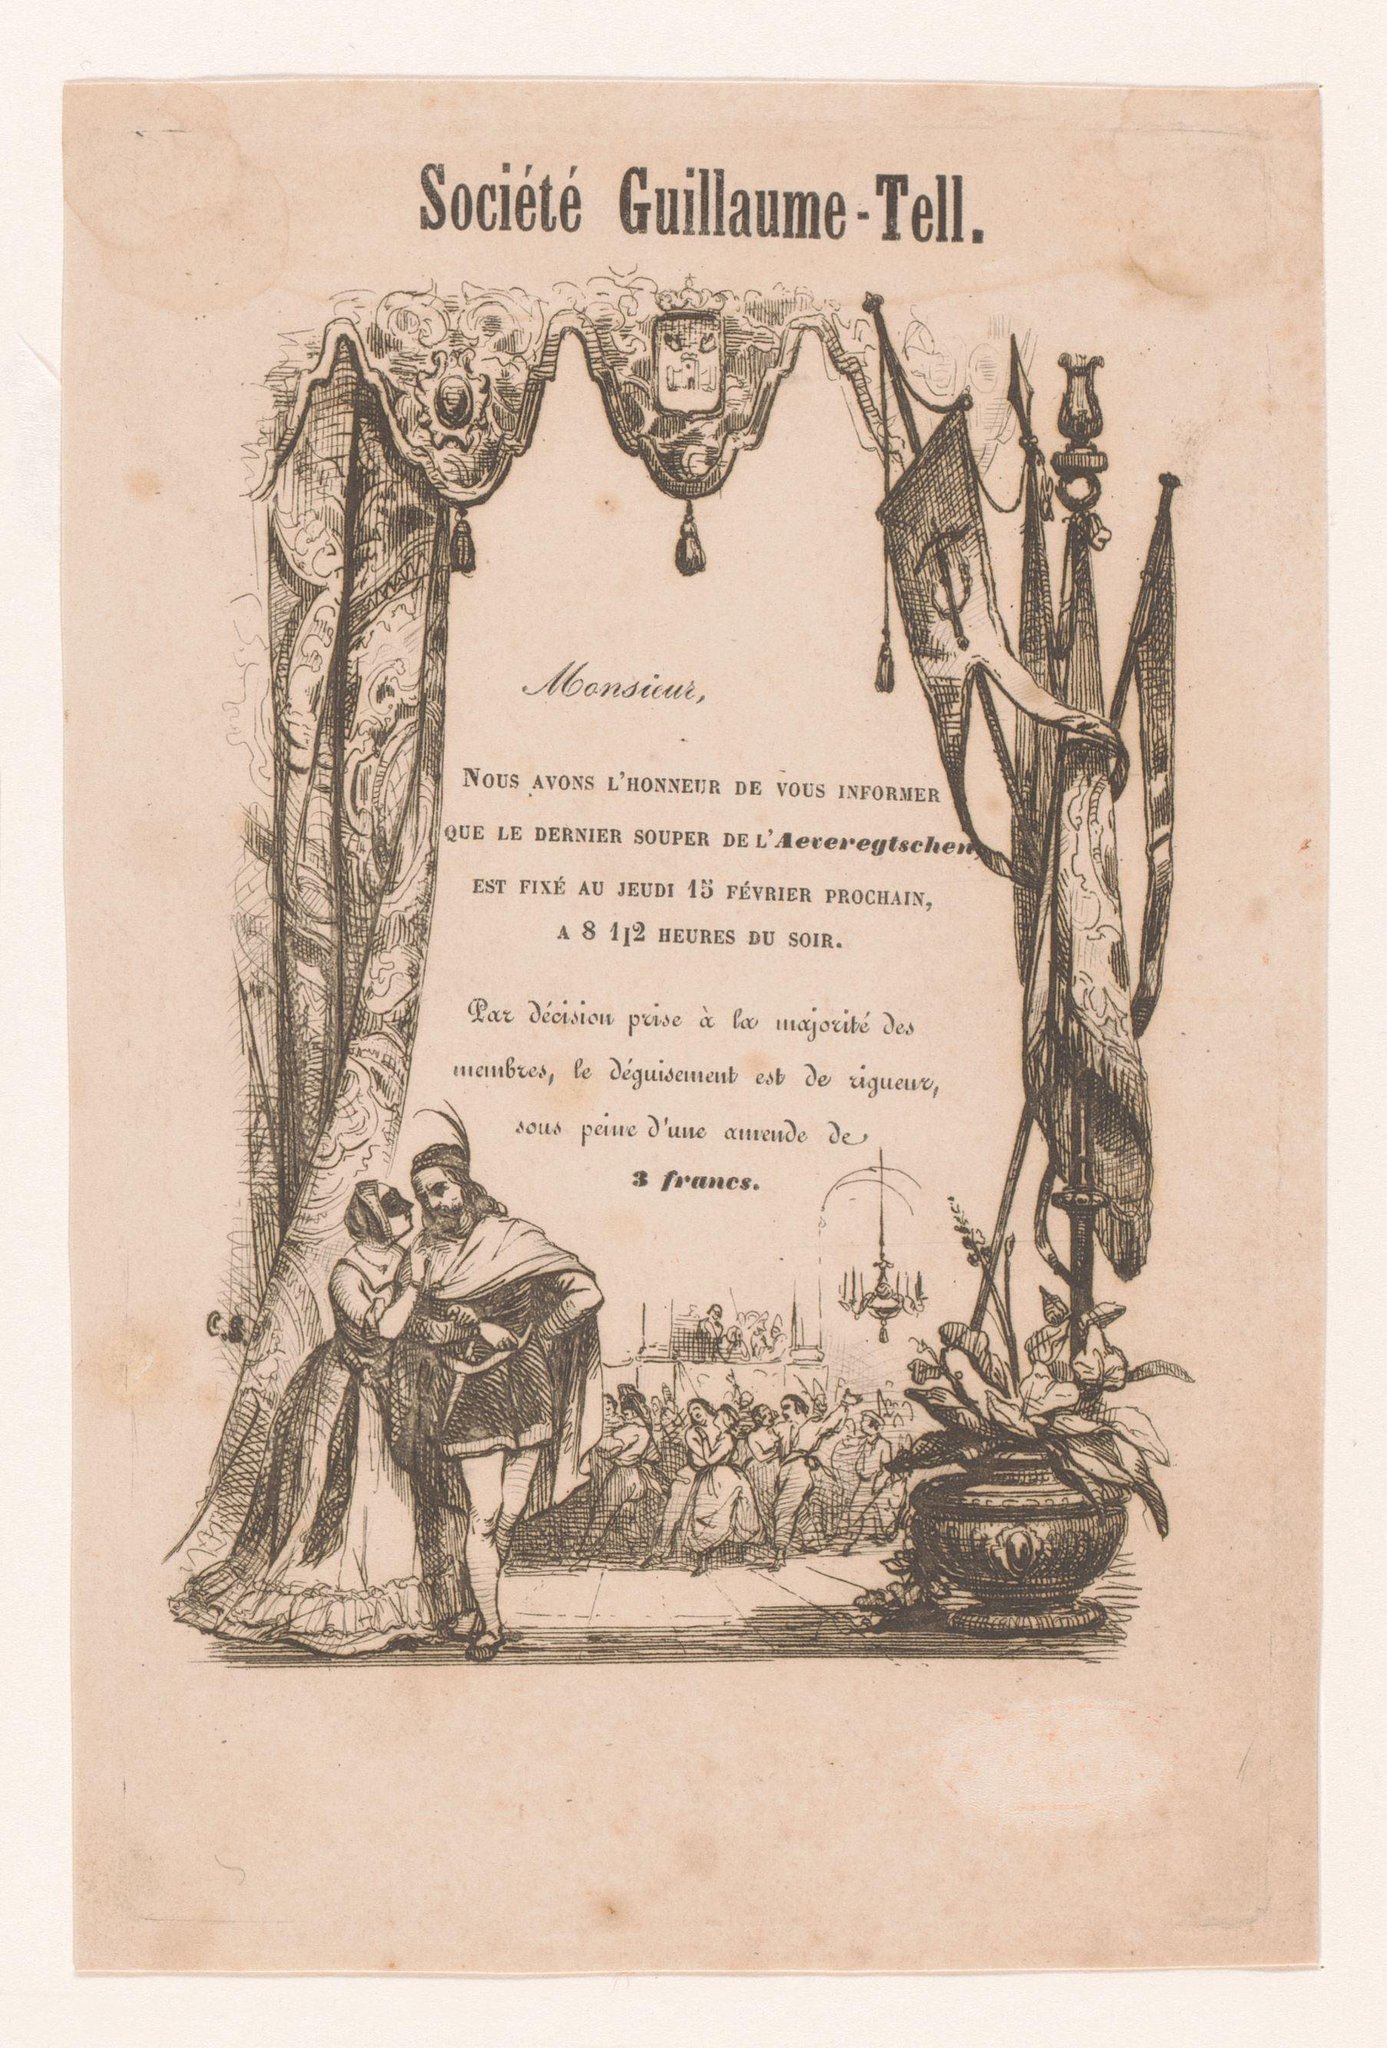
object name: print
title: Man en gemaskerde vrouw bij een danszaal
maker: corneille seghers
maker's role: draughtsman, print maker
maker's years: 1814-1869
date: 1844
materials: paper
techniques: etching, letterpress printing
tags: masquerade, masked ball, group dancing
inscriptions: collector's mark: Lugt 2276, collector's mark: Lugt 2228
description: Uitnodiging voor het laatste diner van de Aeveregtschen bij de Société Guillaume-Tell. Van deze prent in de staat met de letter, bestaat nog een versie waar dezelfde prent als programma van een dansavond dient. Zie RP-P-1888-A-13653.